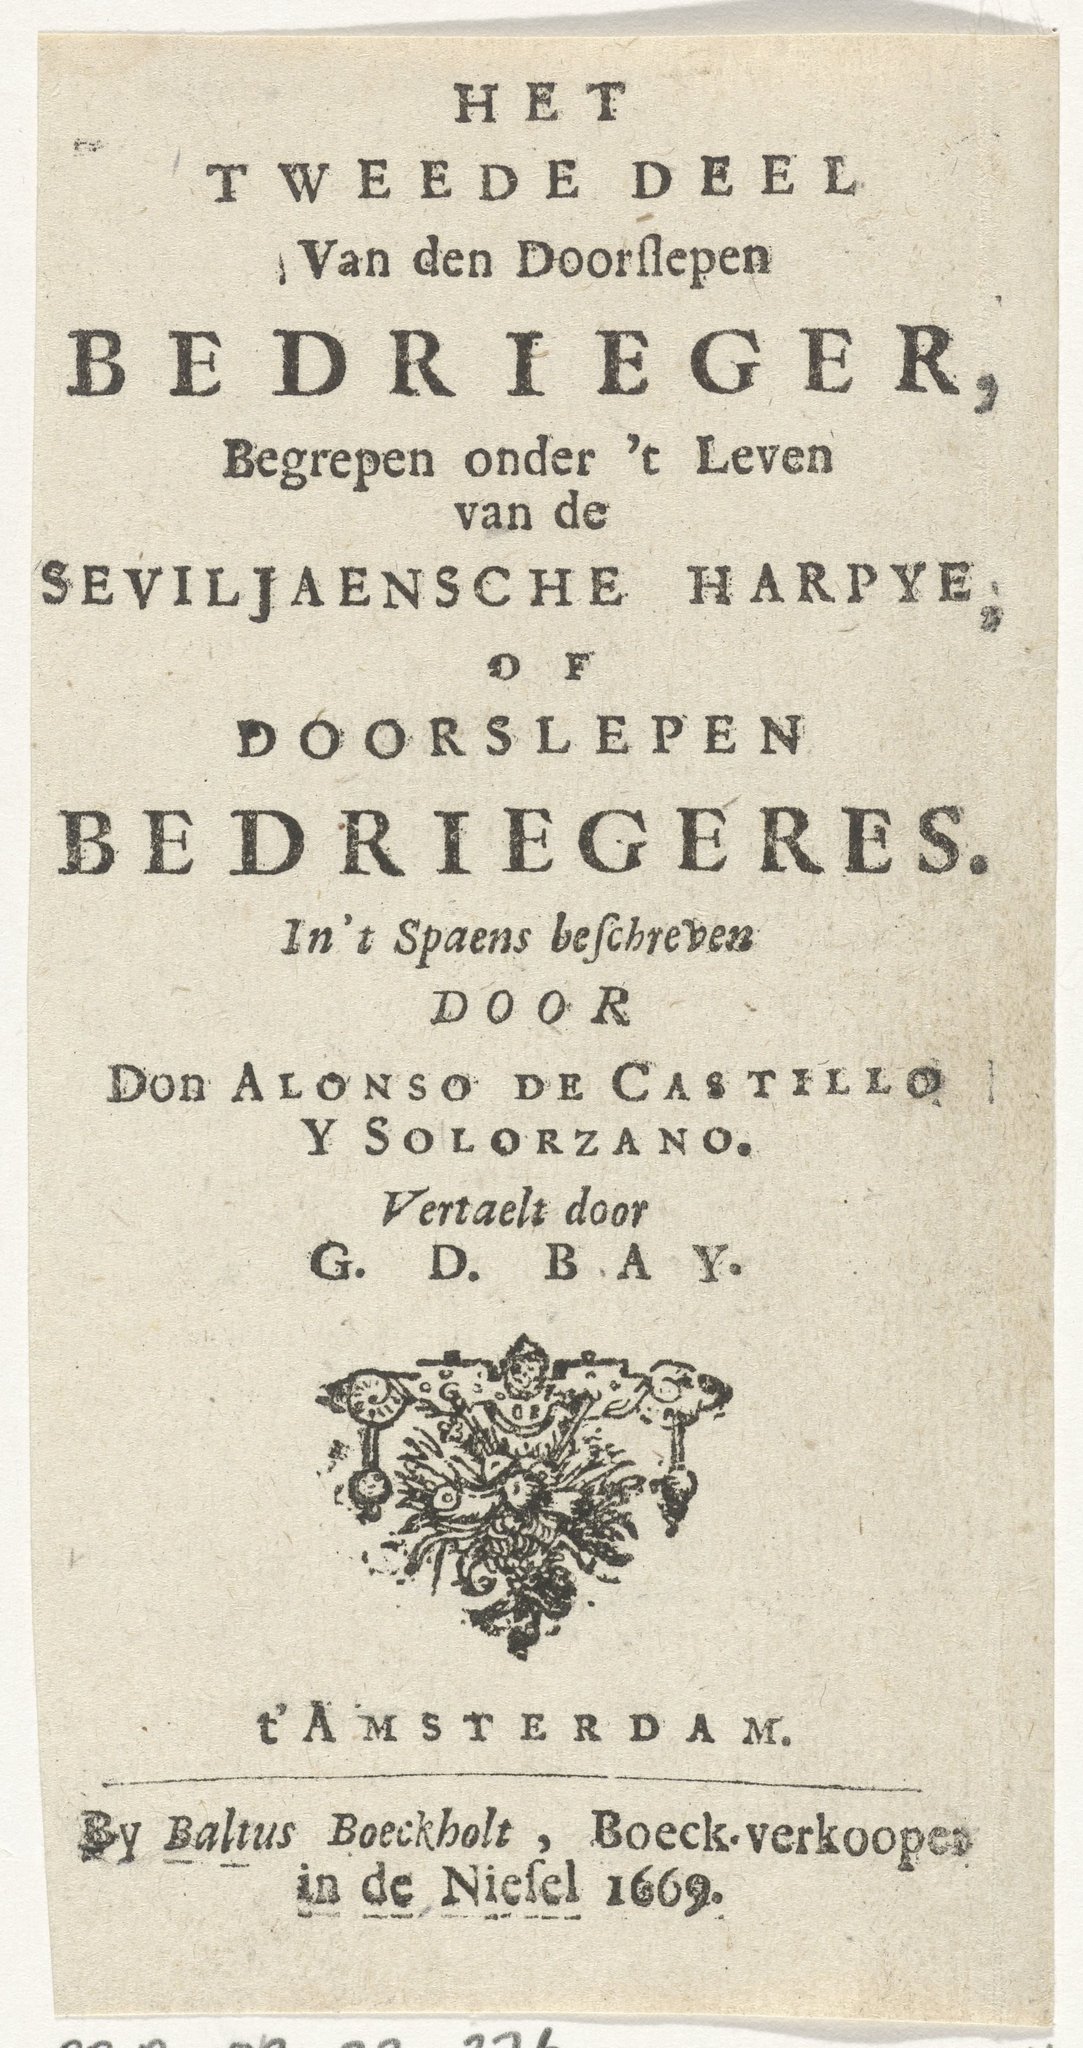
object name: titelblad, titelpagina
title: Titelpagina voor: A. de Castillo Solórzano, Het tweede deel van den doorsleepen bedrieger, 1669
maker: baltes boekholt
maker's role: publisher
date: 1669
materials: paper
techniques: letterpress printing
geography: amsterdam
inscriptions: collector's mark: Lugt 2228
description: Titelpagina voor: Castillo Solórzano, Alonso de. Het tweede deel van den doorsleepen bedrieger, begrepen onder 't leven van de Seviljaensche harpye of doorslepen bedriegeres. Amsterdam: Baltes Boekholt, 1669.